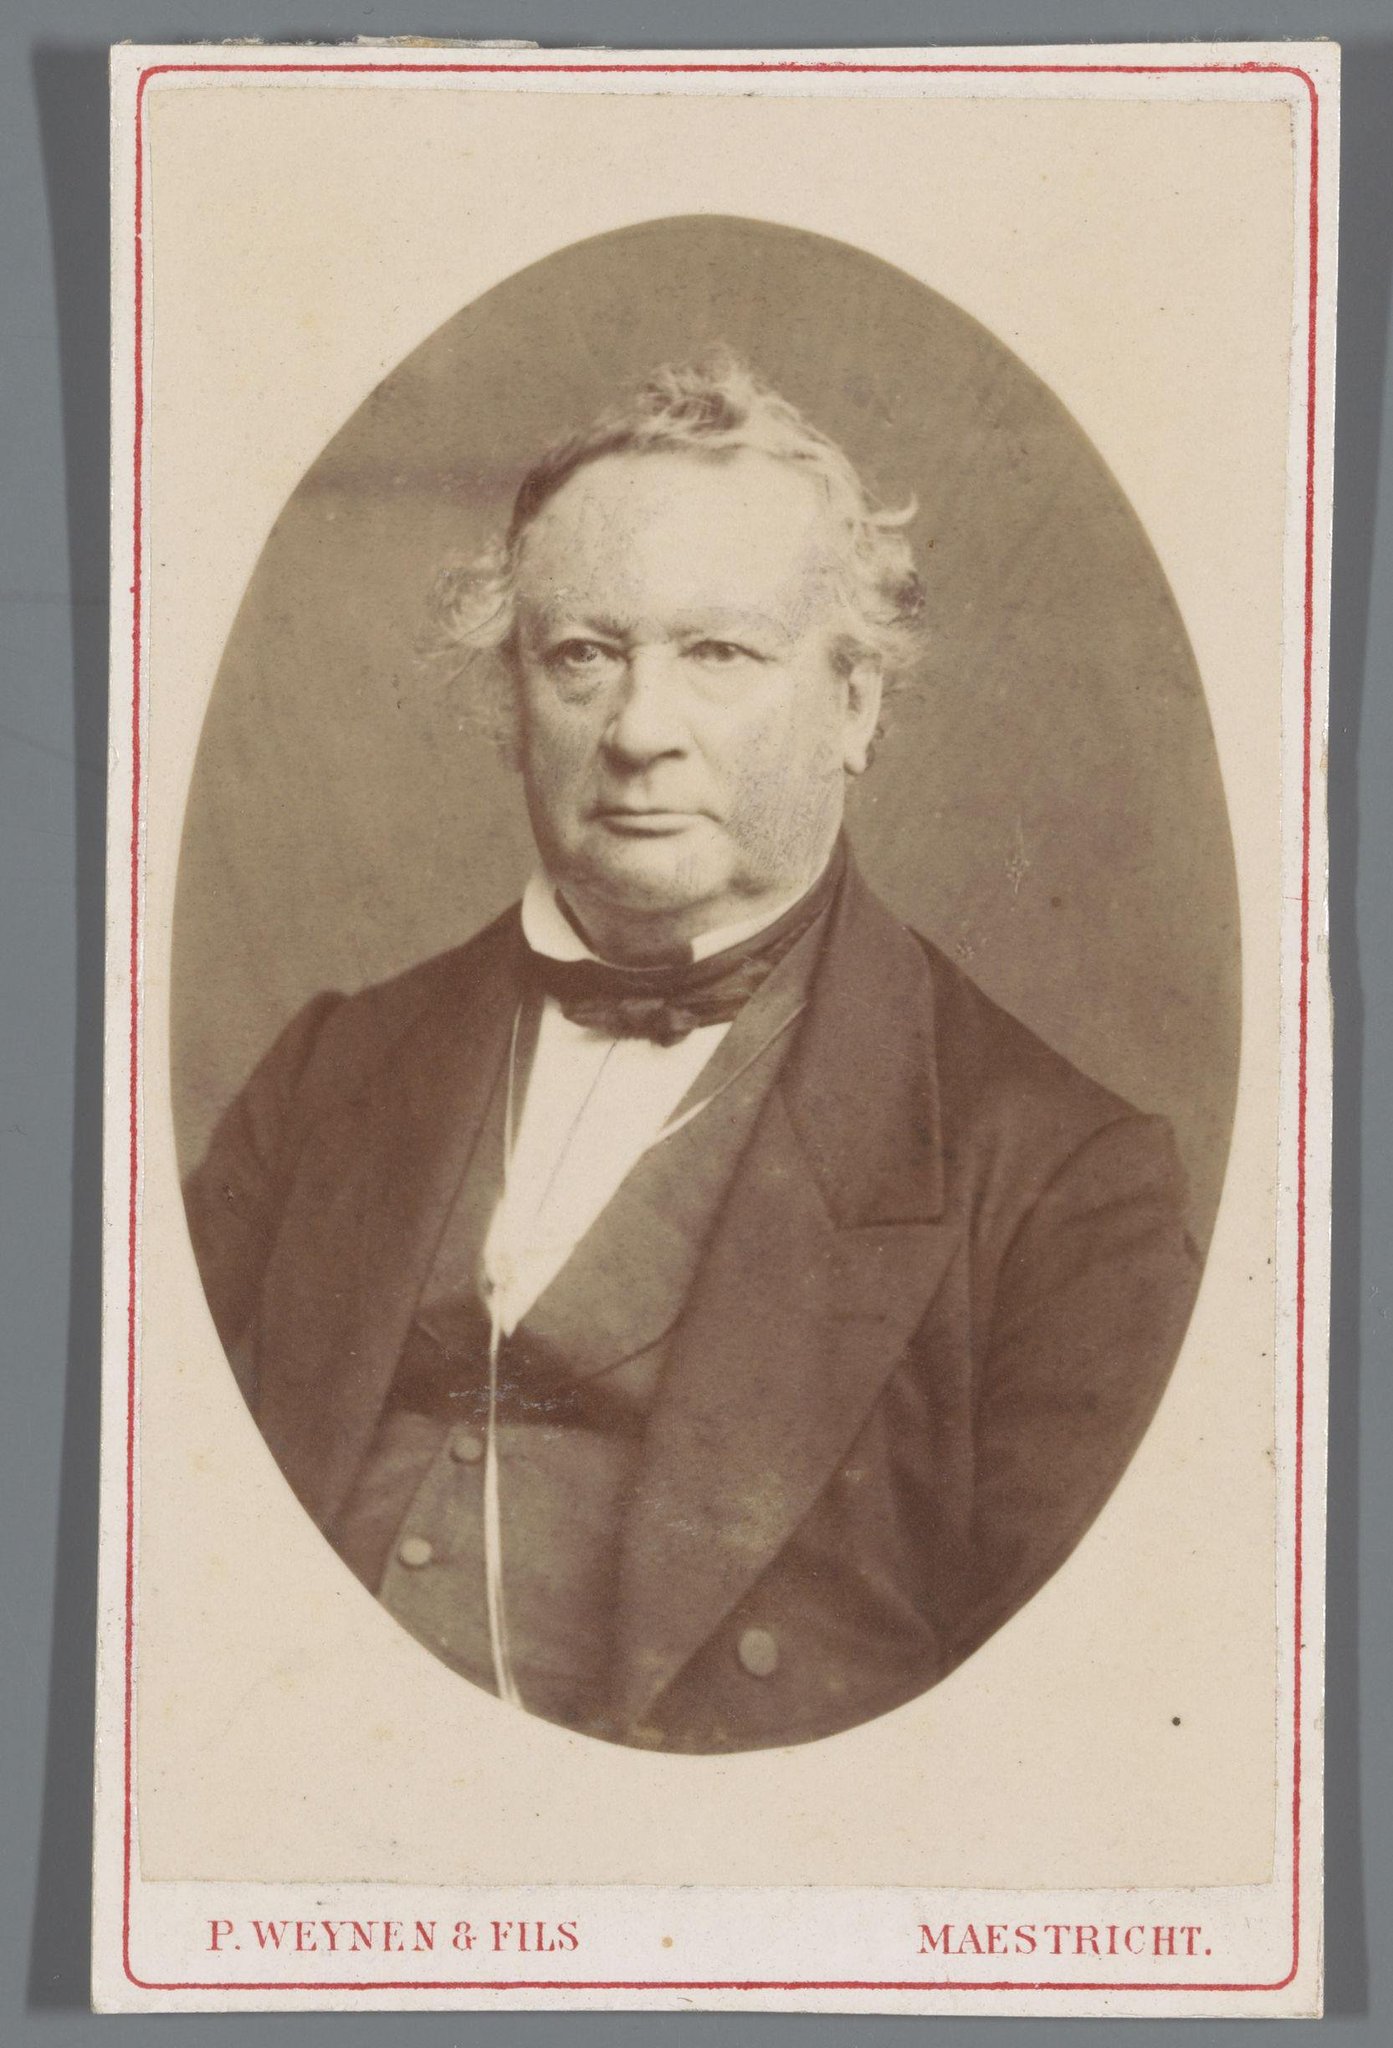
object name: semi enamel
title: Portret van een onbekende man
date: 1854-1865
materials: cardboard, celluloid, paper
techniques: albumen print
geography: maastricht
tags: adult man, anonymous historical person portrayed, maastricht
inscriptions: inscription: ‘No.../ Photographie/ P. Weynen & Fils/ Rue du Casque, 1776./ Maestricht./ Les clichés sont conservés.’, inscription: ‘P. Weynen & Fils/ Maestricht.’